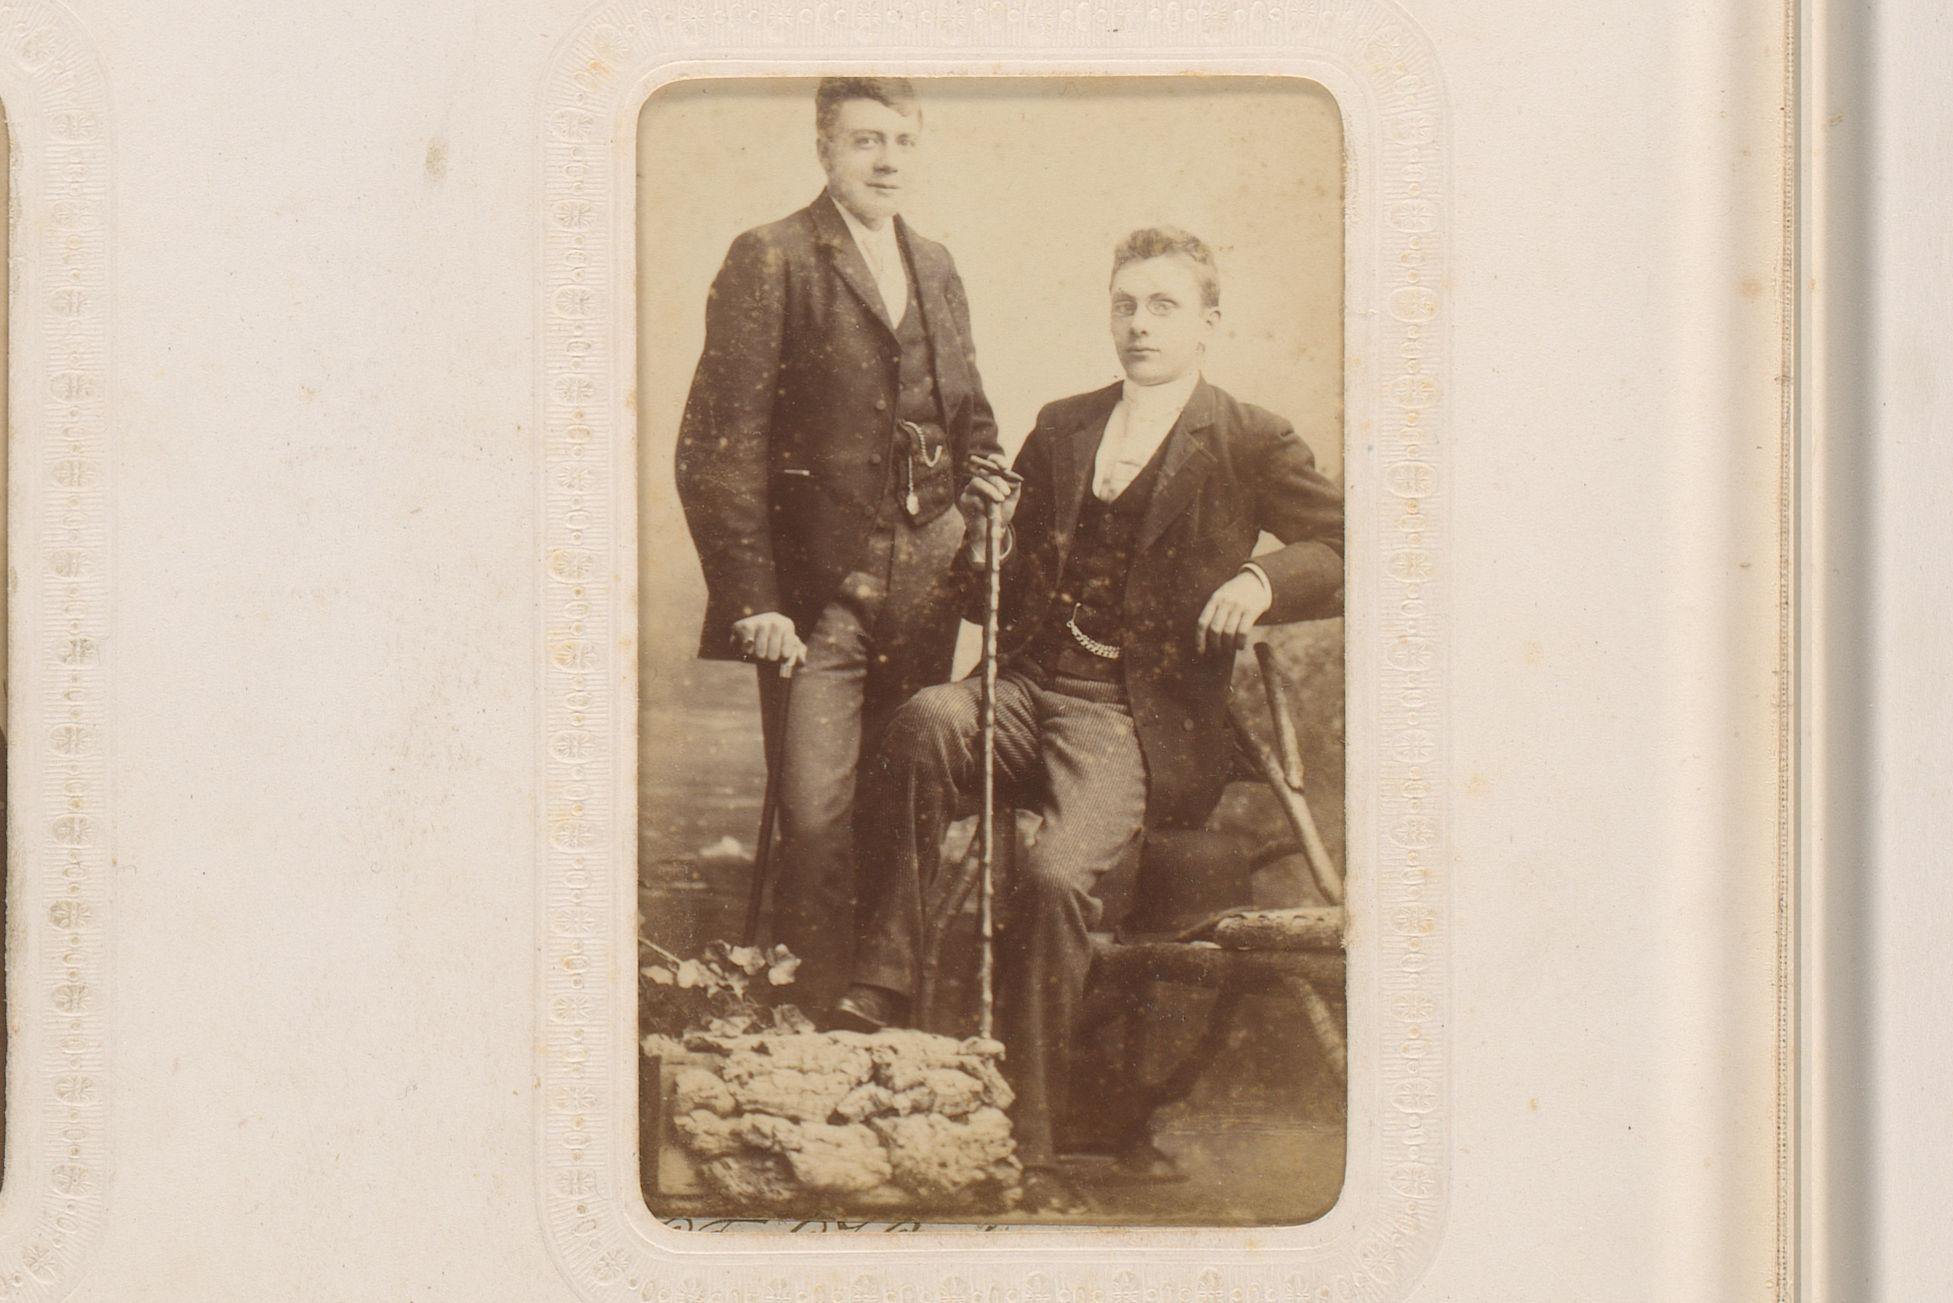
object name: album leaf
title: Portret van een staande man met wandelstok en een zittende man met bril, sigaar en wandelstok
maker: Anonymous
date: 1860-1900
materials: cardboard, photographic support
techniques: albumen print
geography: netherlands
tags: eyeglasses, spectacles, adult man (+ two persons), walking-stick, staff, historical persons